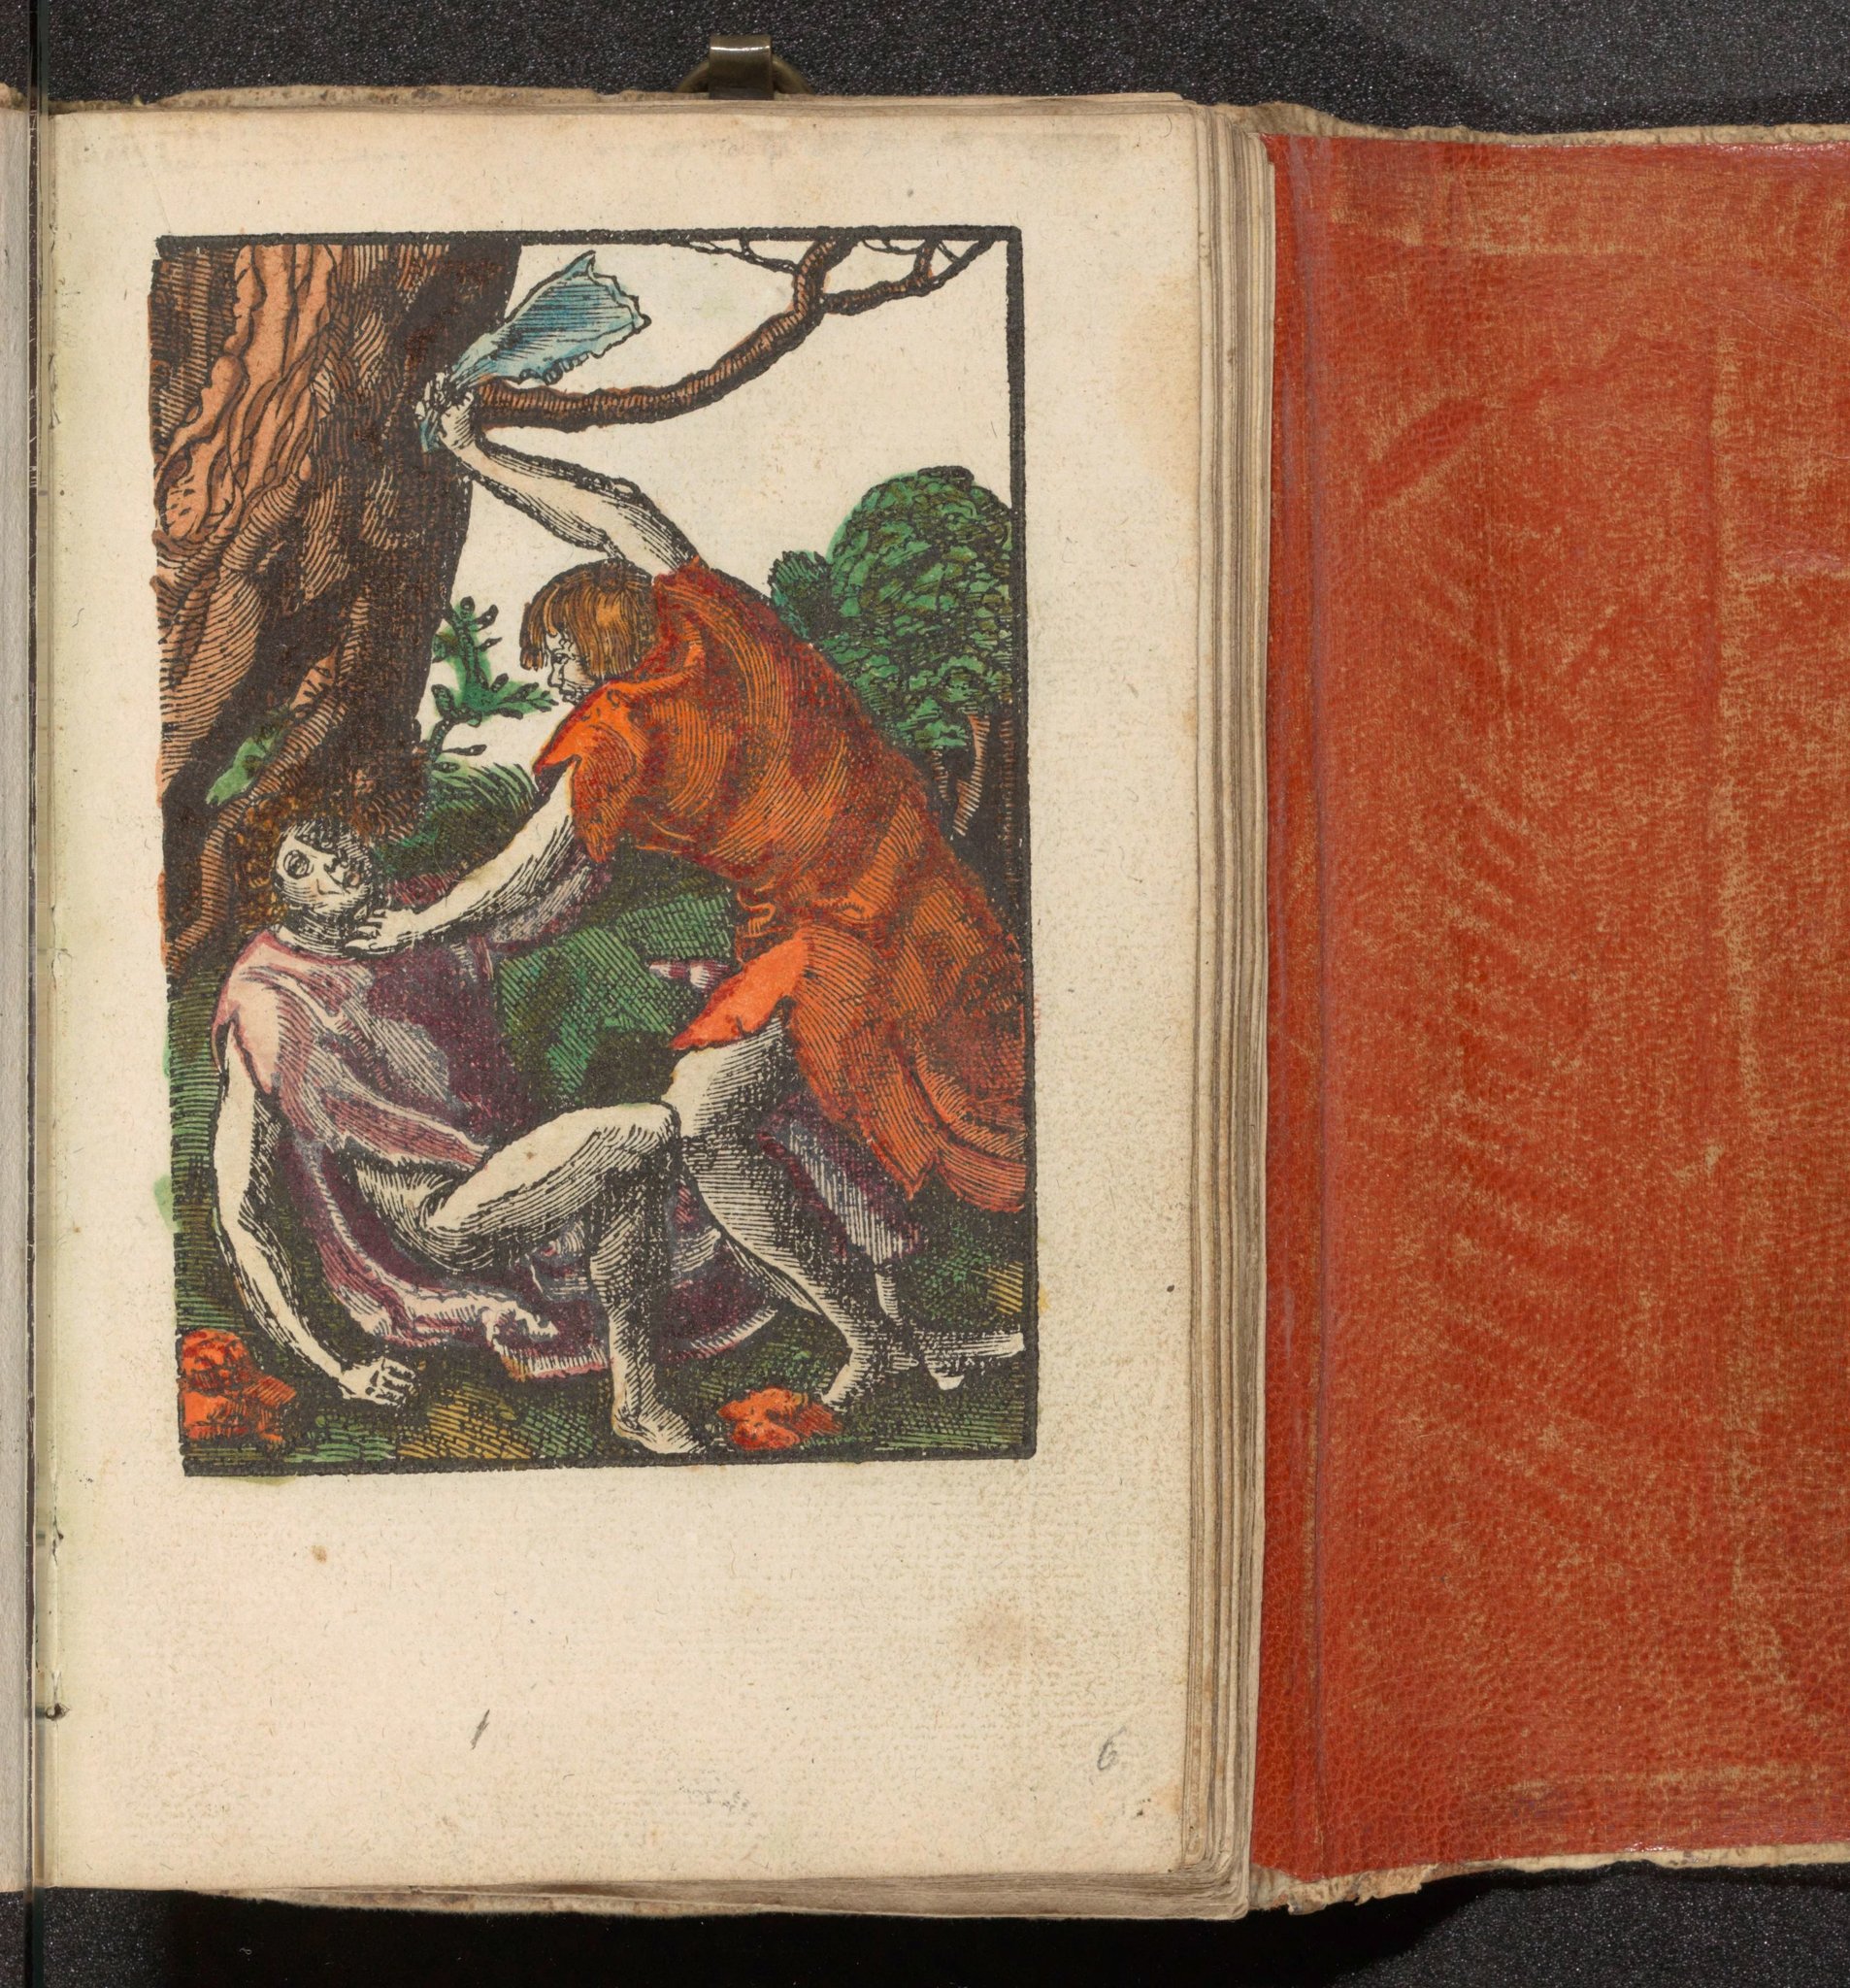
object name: book illustration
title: Kaïn doodt Abel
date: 1530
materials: paper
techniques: hand coloring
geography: low countries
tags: the killing of abel: cain slays him with a stone, a club or a jaw-bone, alternatively with a spade or another tool as weapon, book in which illustrations are essential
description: Kaïn slaat zijn broer Abel dood met het kaakbeen van een ezel. Prent maakt deel uit van een boek.